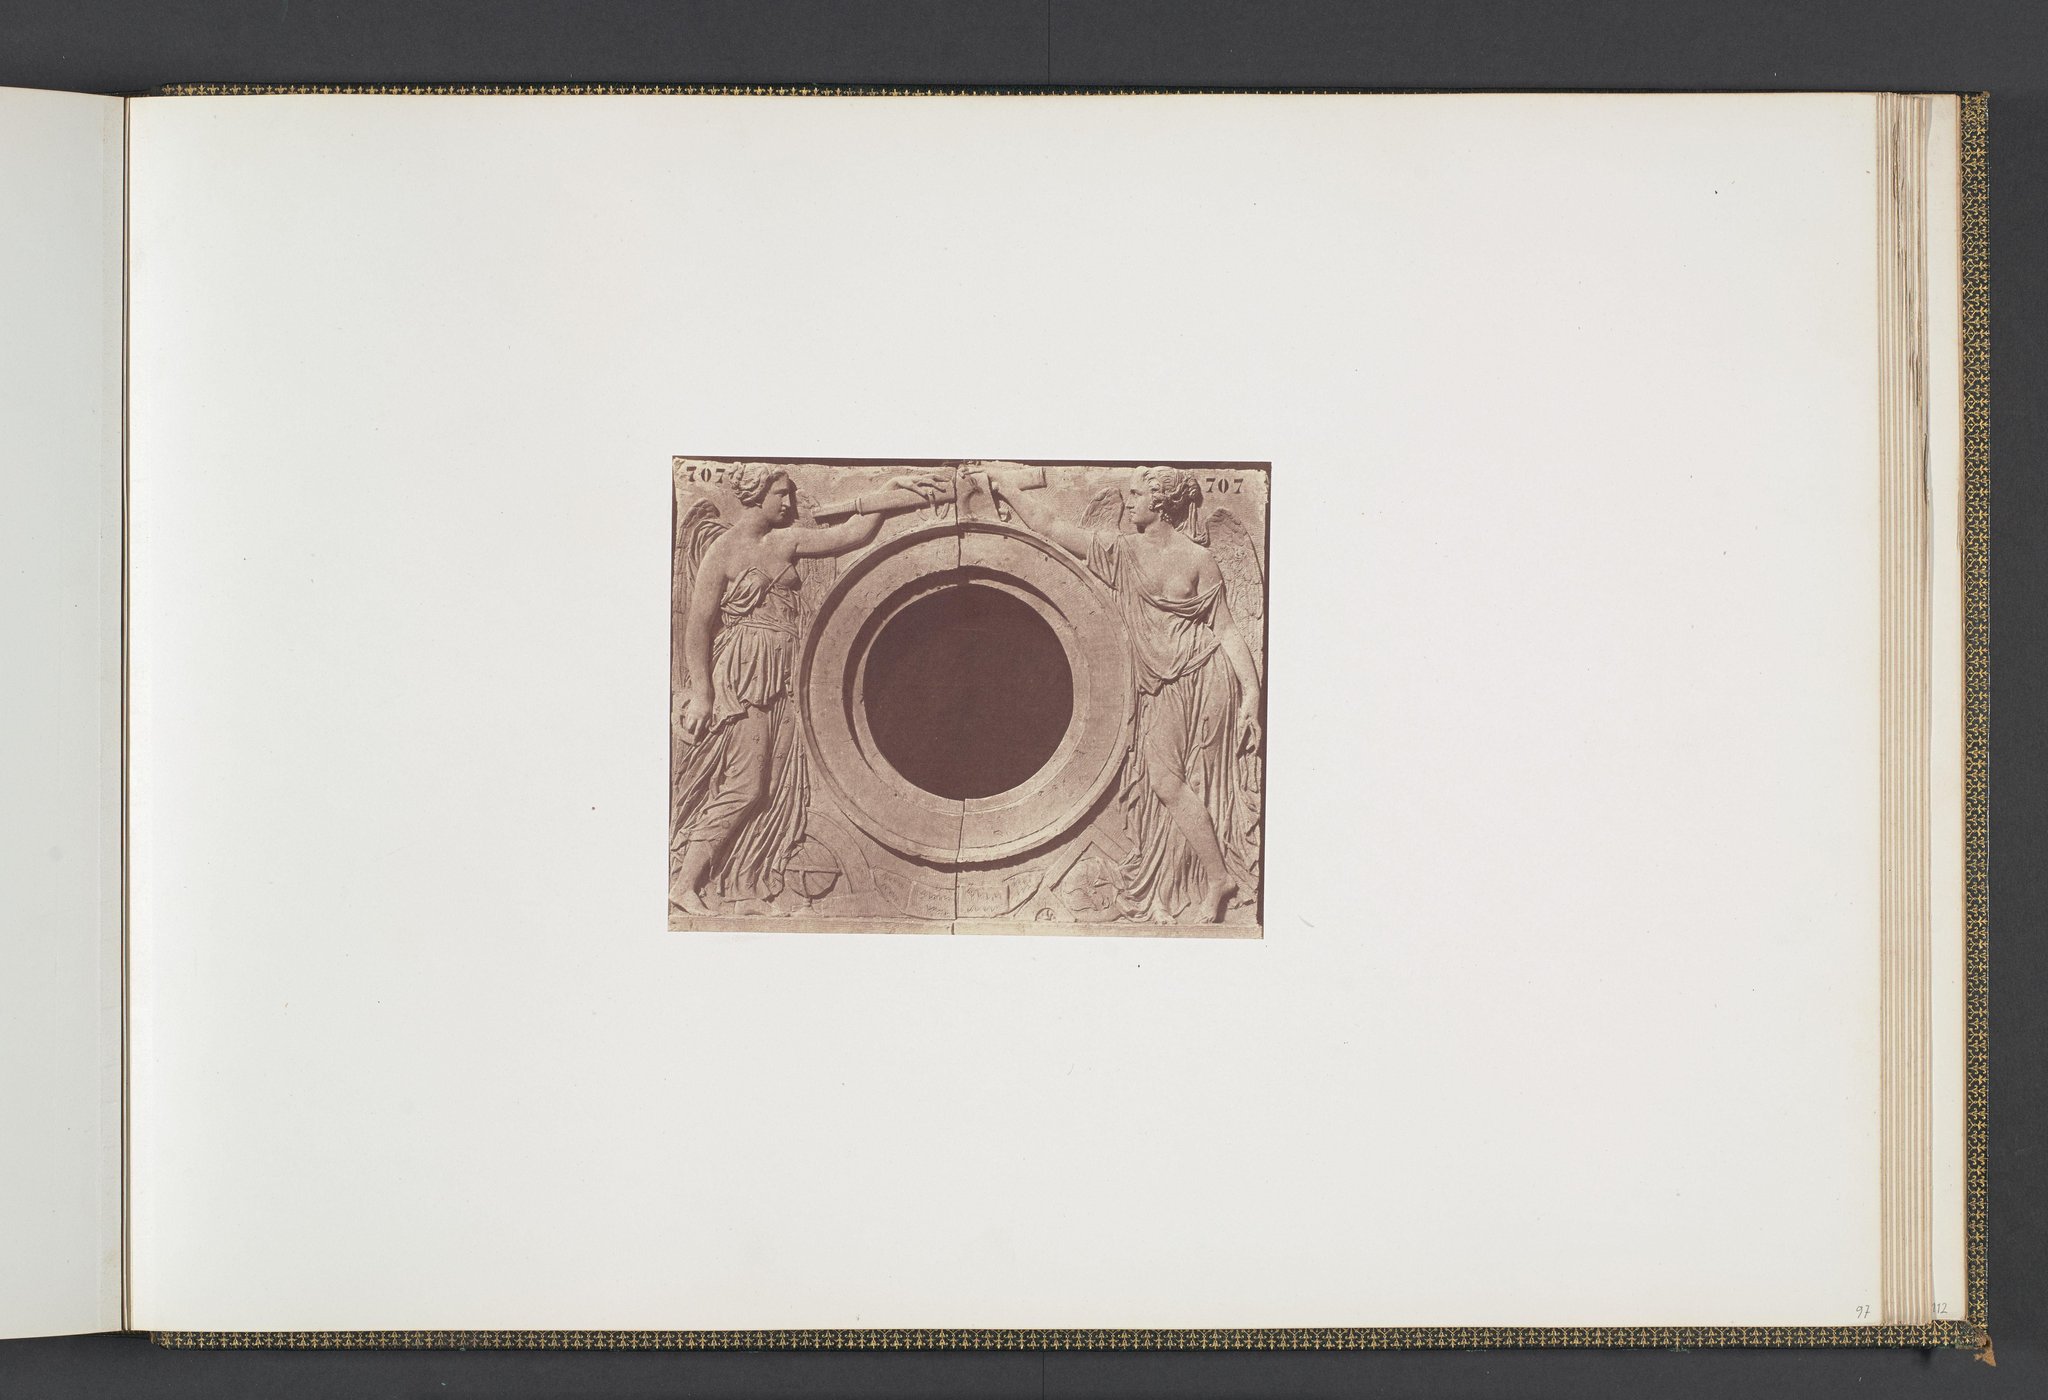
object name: photograph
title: Gipsmodellen voor beeldhouwwerken op het Palais du Louvre: "L'Astronomie et la Géométrie" door Jean-Esprit Marcellin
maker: édouard denis baldus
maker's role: fotograaf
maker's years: 1813-1889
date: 1855-1857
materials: paper, photographic support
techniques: salted paper print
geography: paris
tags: piece of sculpture, reproduction of a piece of sculpture, permanent exhibition, museum, paris, tuileries palace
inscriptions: number: ‘707’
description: Onderdeel van Réunion des Tuileries au Louvre 1852-1857, album 2.